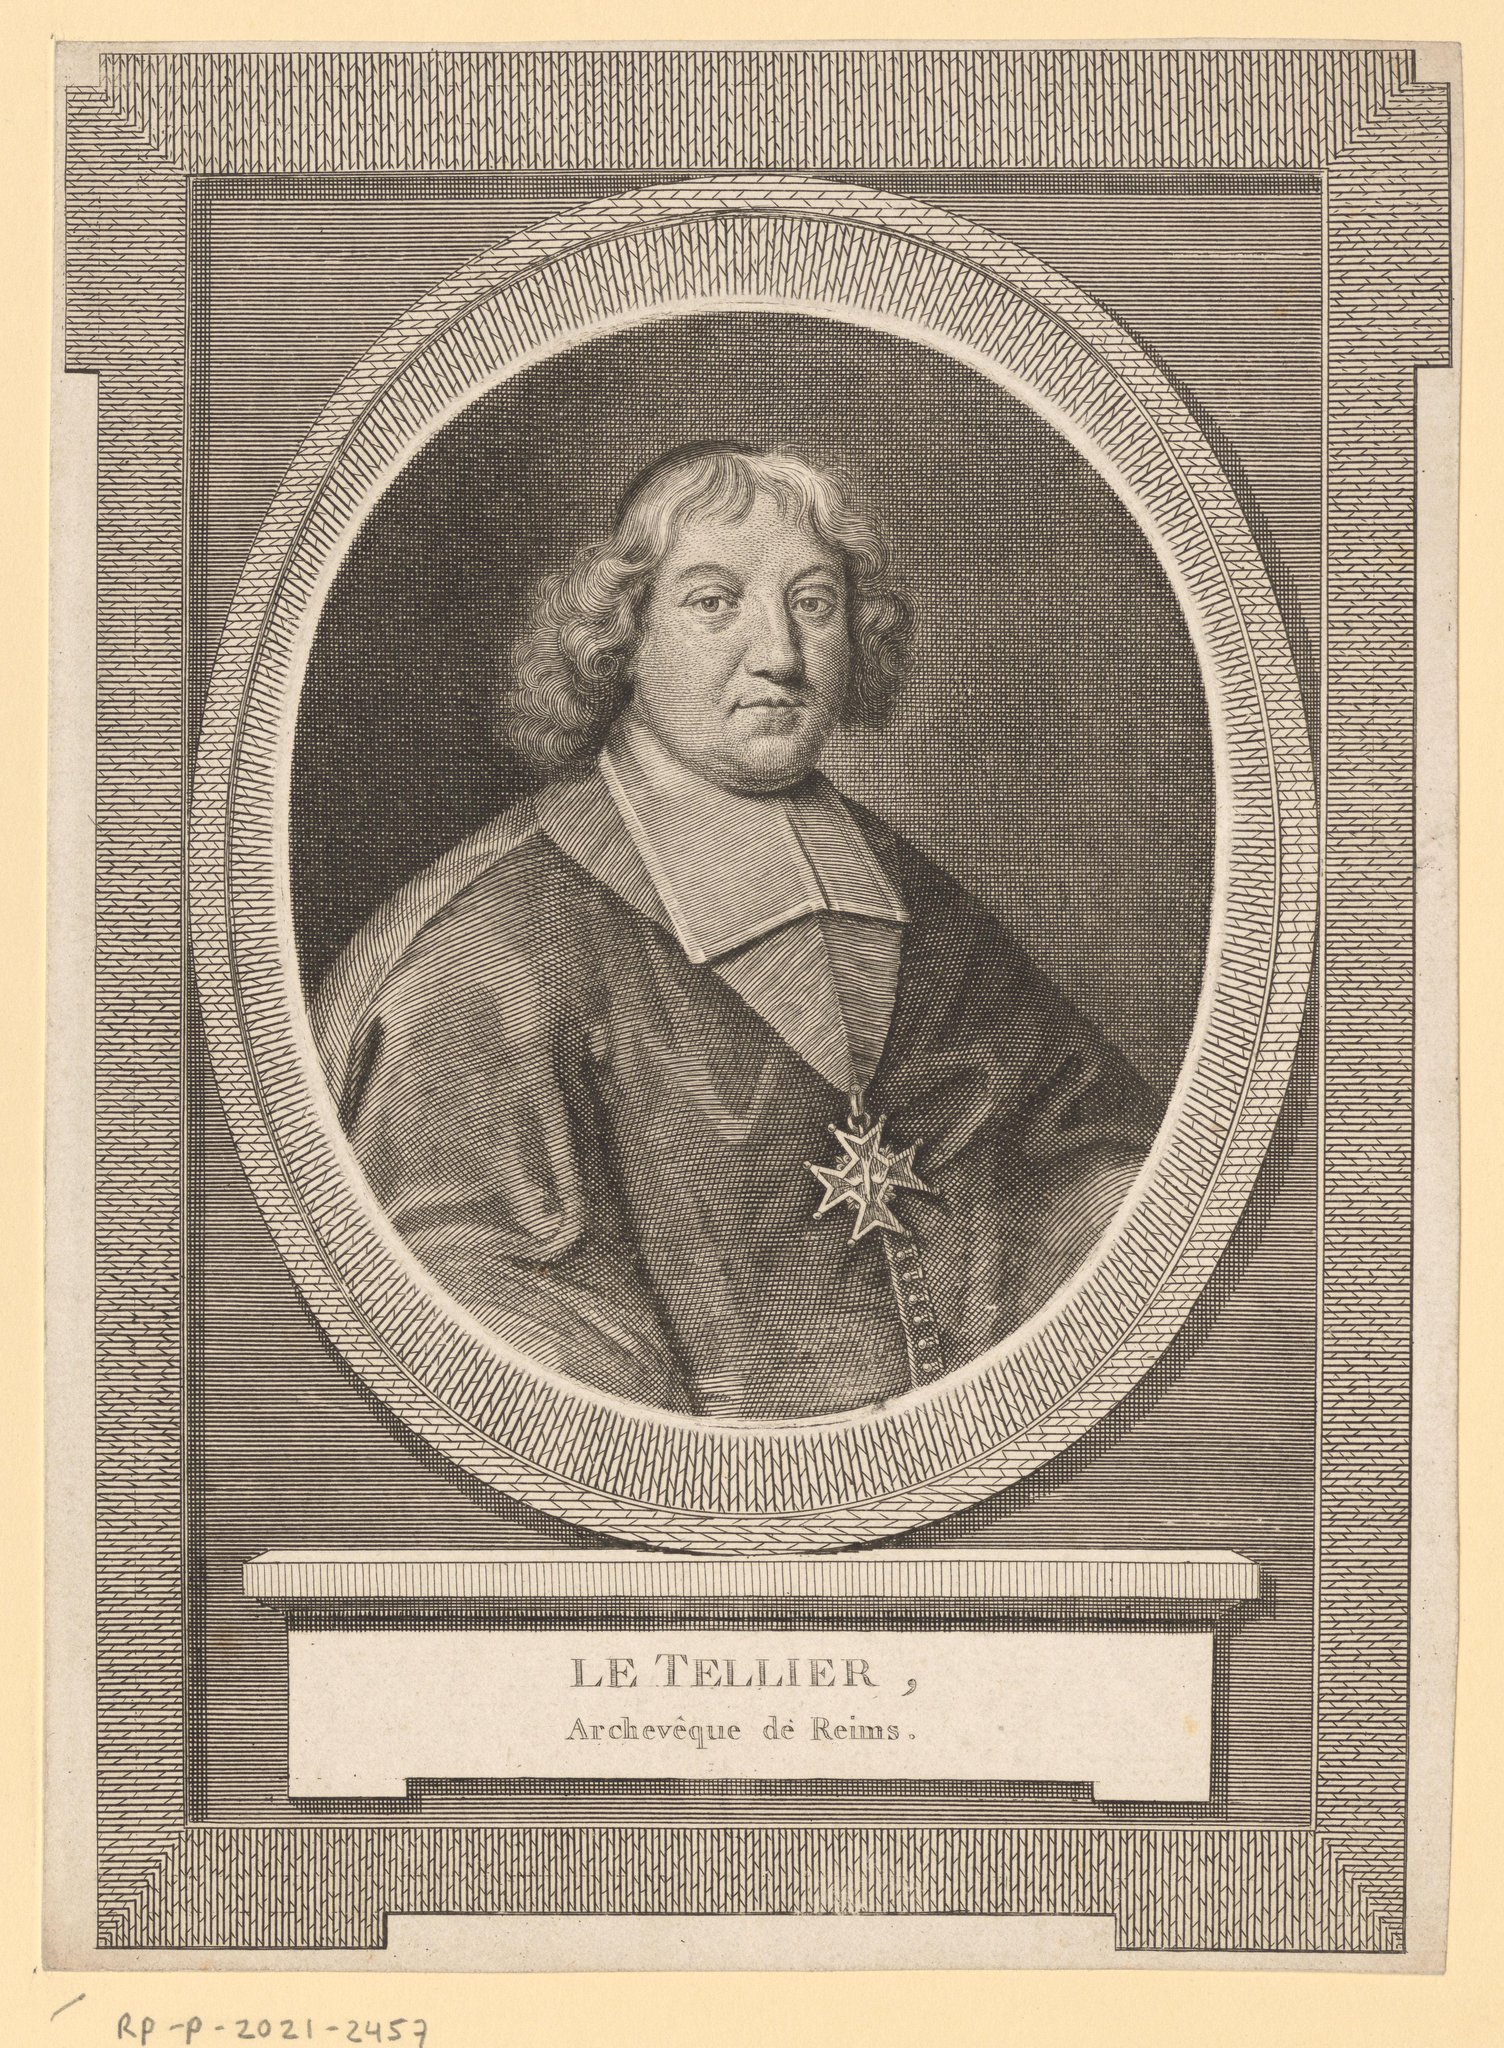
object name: print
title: Portret van Charles Maurice Le Tellier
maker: Anonymous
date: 1700-1788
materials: paper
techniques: engraving, etching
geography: france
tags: priest, charles-maurice le tellier, archbishop, bishop, etc. (roman catholic), historical persons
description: Prent is met een andere omlijsting (zie RP-P-2021-2458) gebruikt in: Les illustres modernes; ou tableau de la vie privée des principaux personnages des deux sexes (...). Parijs: Leroy, 1788, dl. 2.